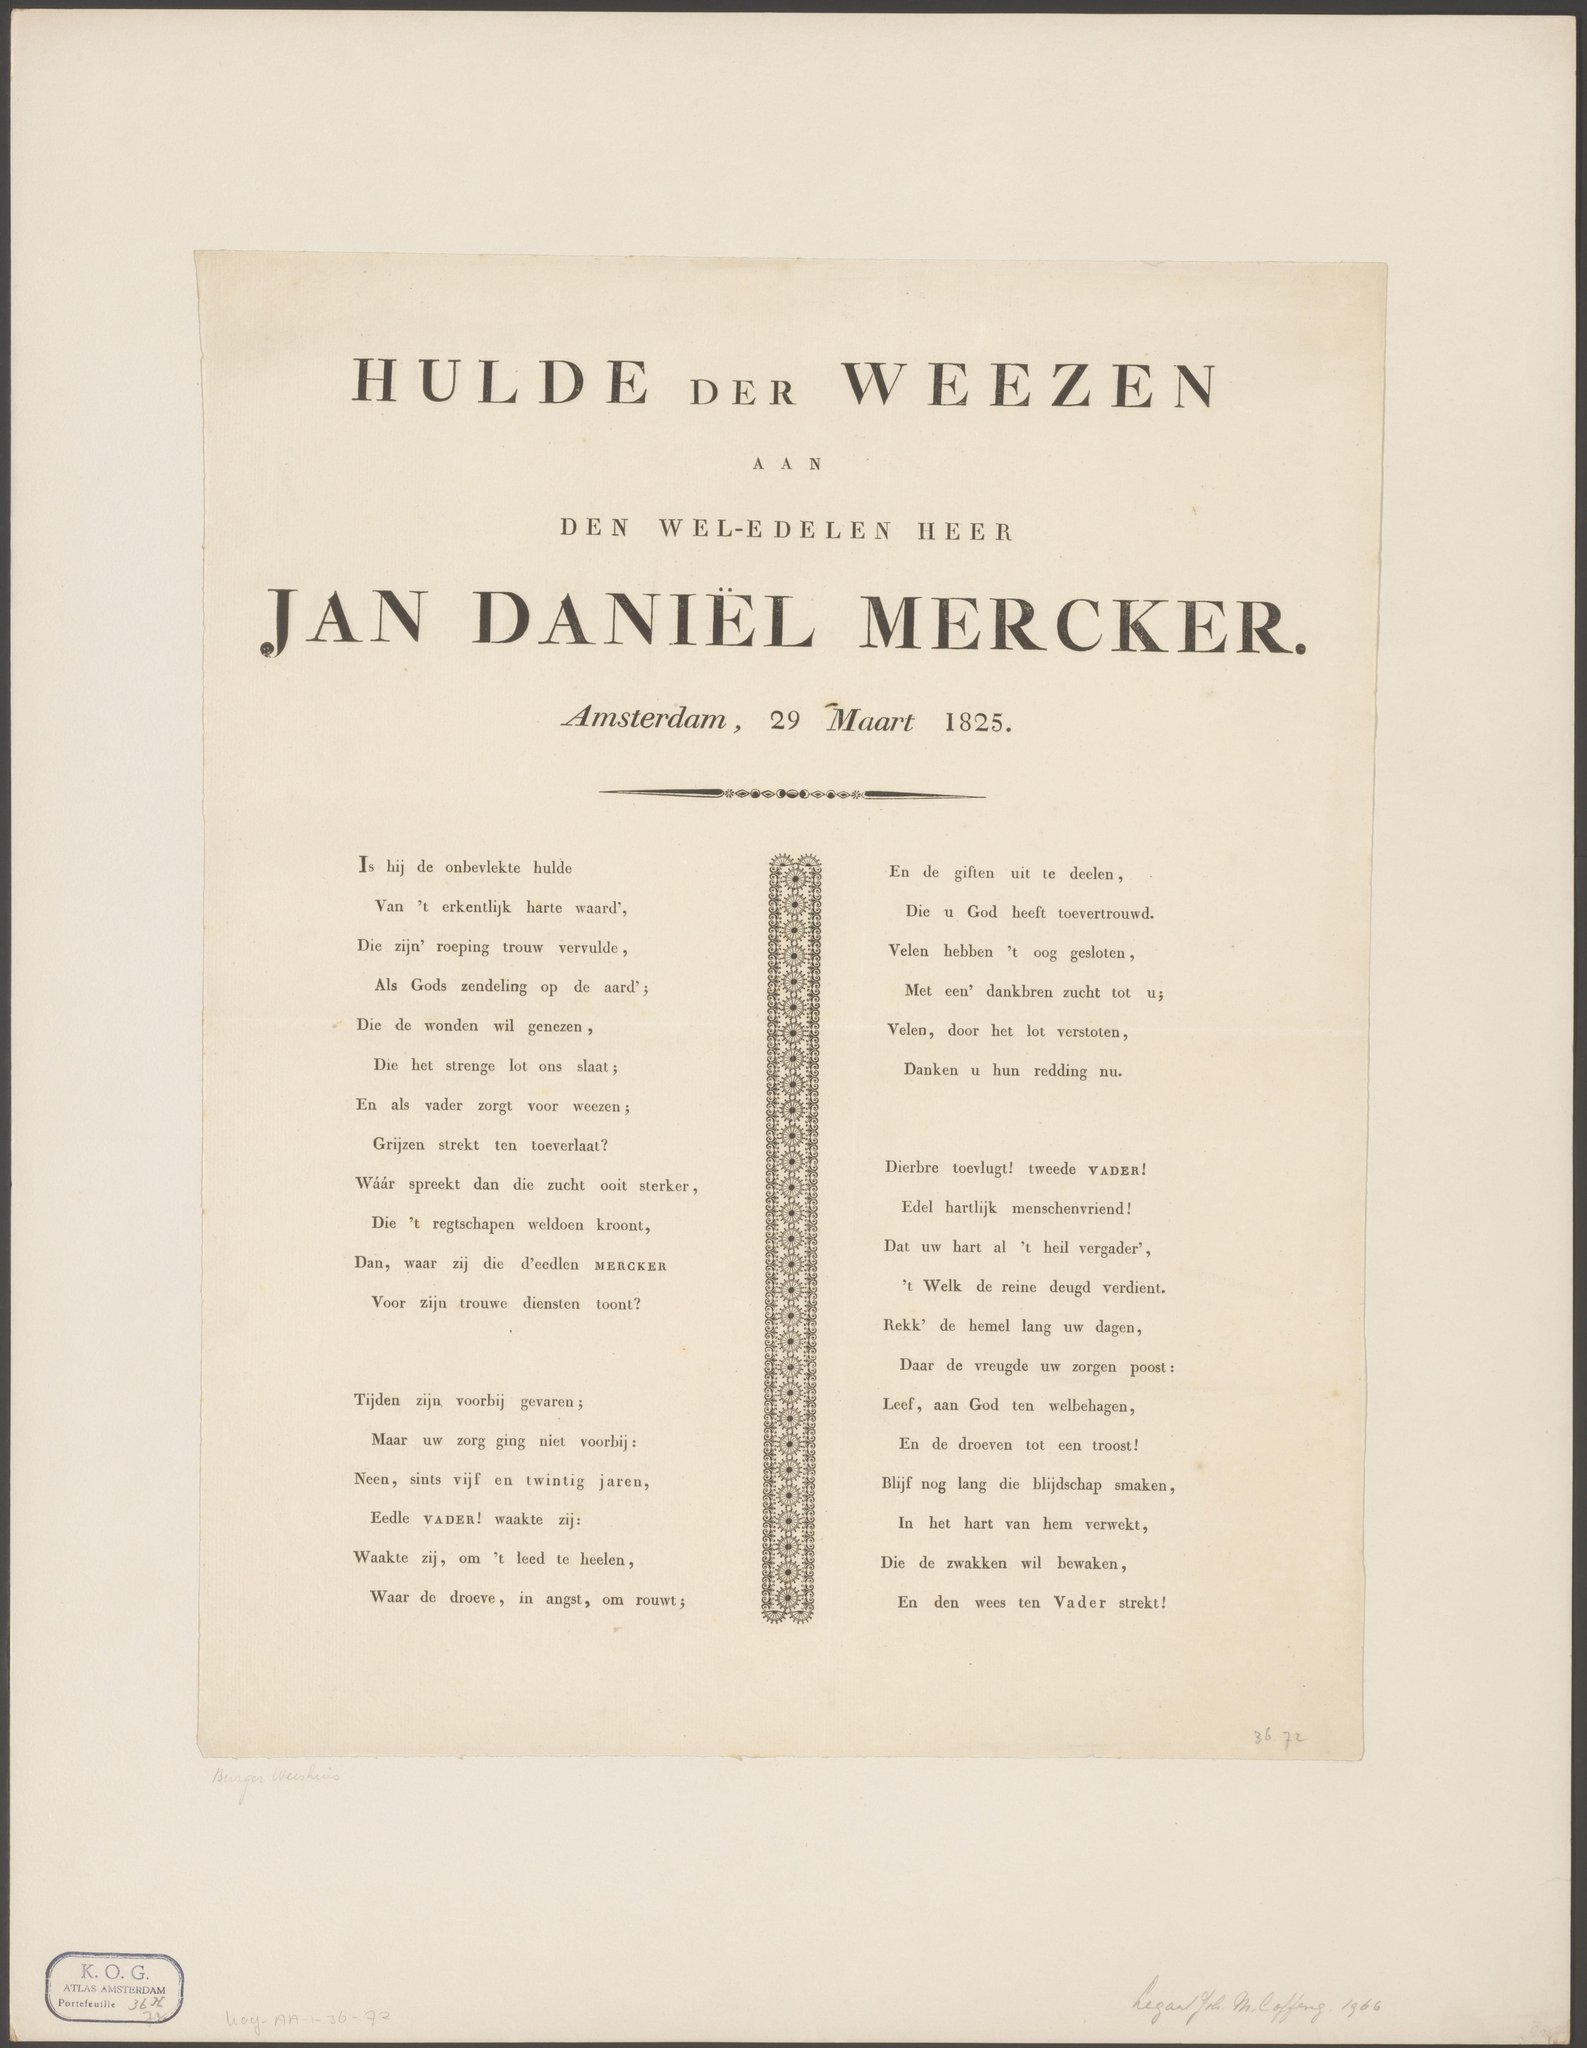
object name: text sheet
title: Hulde der Weezen aan den wel-edelen heer Jan Daniël Mercker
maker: Anonymous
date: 1880-1920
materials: paper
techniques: letterpress printing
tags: orphanage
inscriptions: collector's mark: Lugt 1641b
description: Vers van de wezen van het Burgerweeshuis aan Jan Daniël Mercker. Onderwerpsrubriek binnen de Atlas Amsterdam: Armwezen en liefdadige instellingen: I. Stadsinrichtingen: Burgerweeshuis.